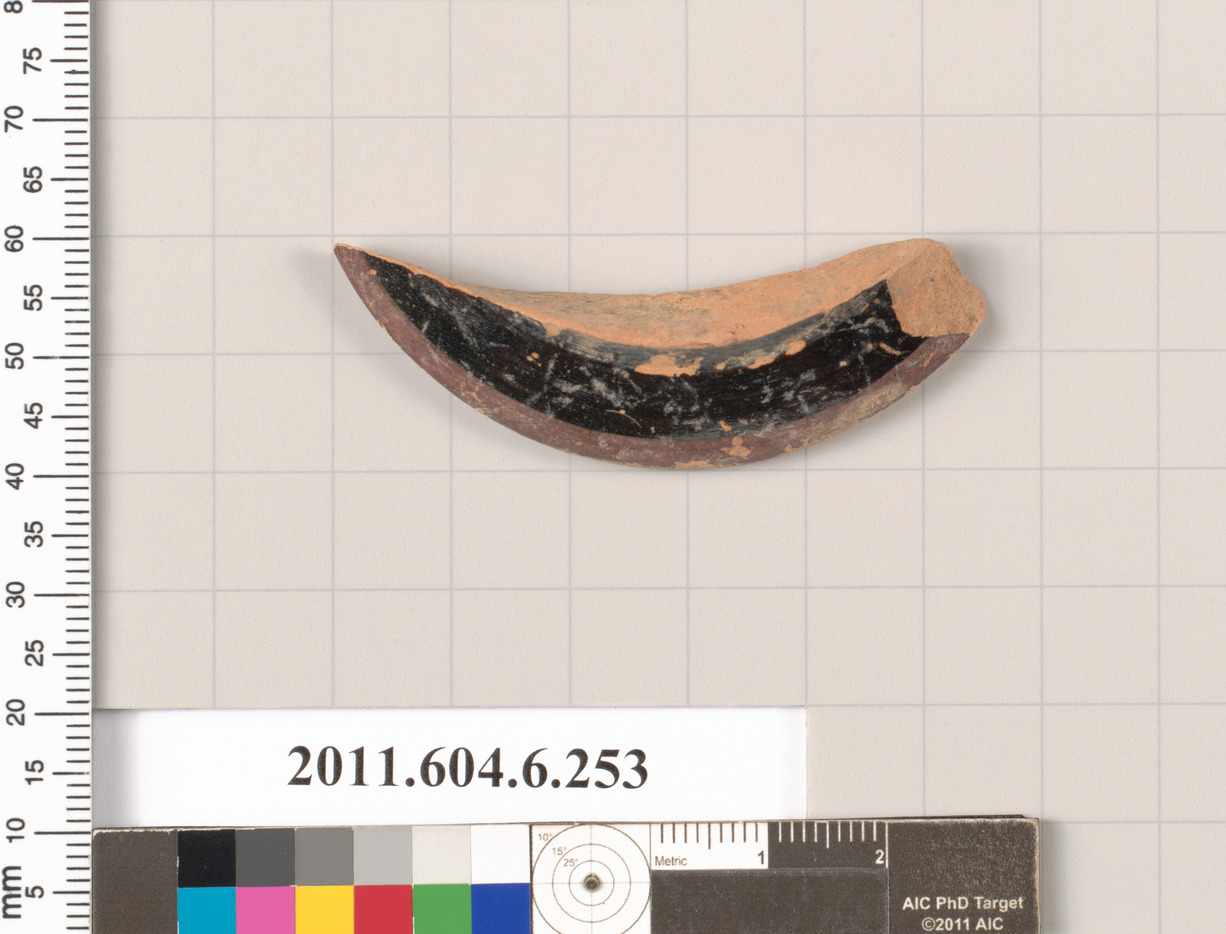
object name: undetermined shape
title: Terracotta fragment of an undetermined shape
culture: greek, attic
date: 600-401 BCE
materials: terracotta